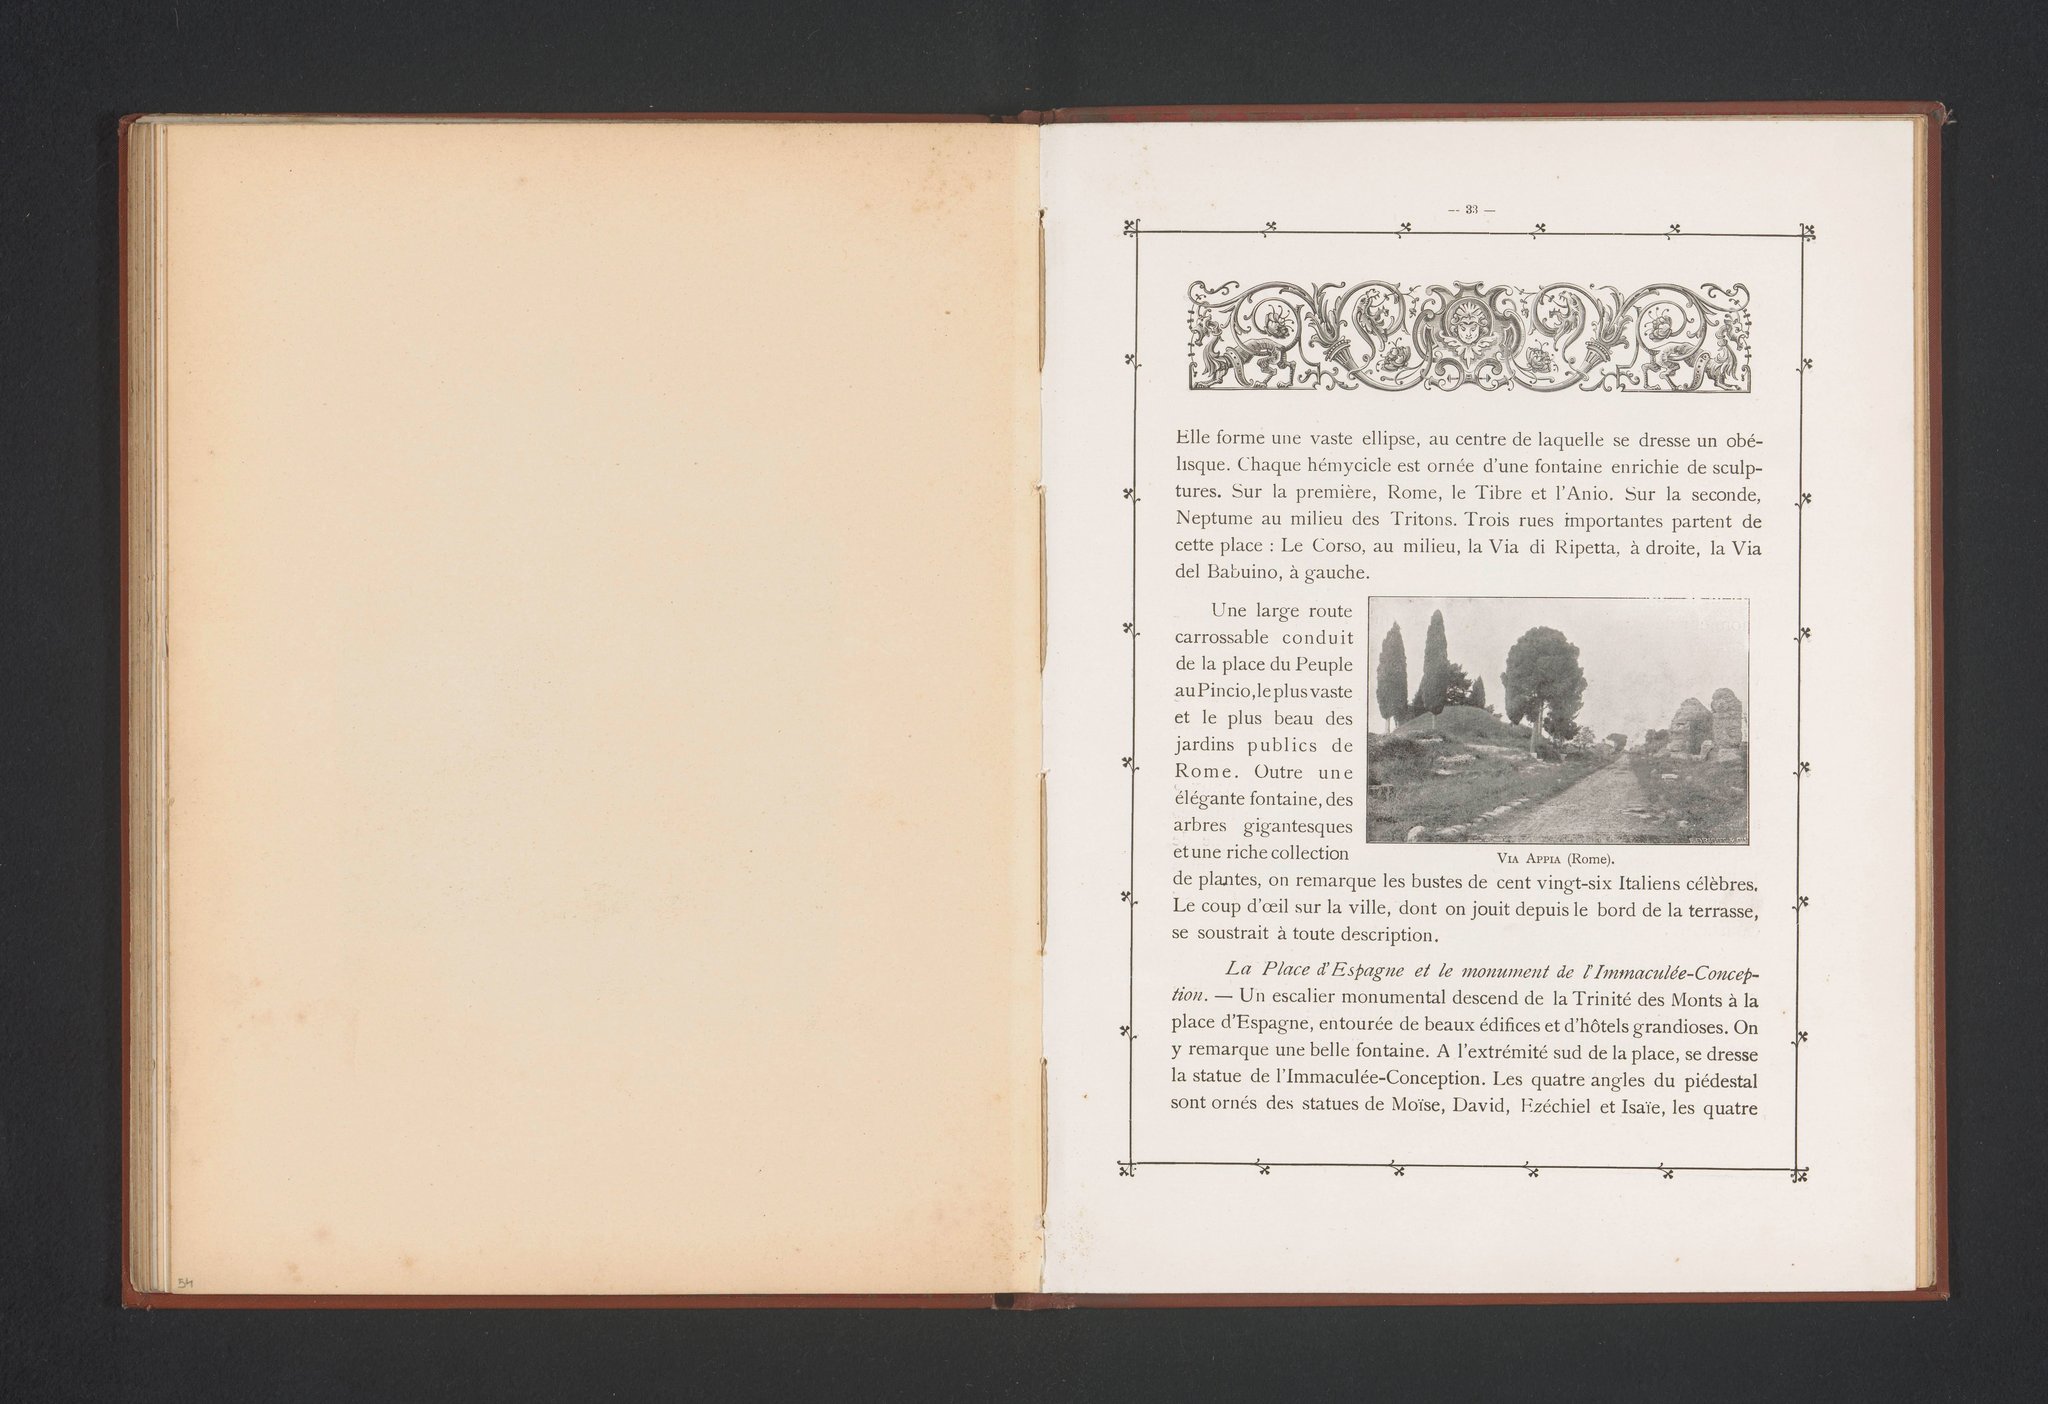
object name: page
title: Via Appia (Rome)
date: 1893-1898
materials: paper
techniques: autotype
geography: via appia antica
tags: street